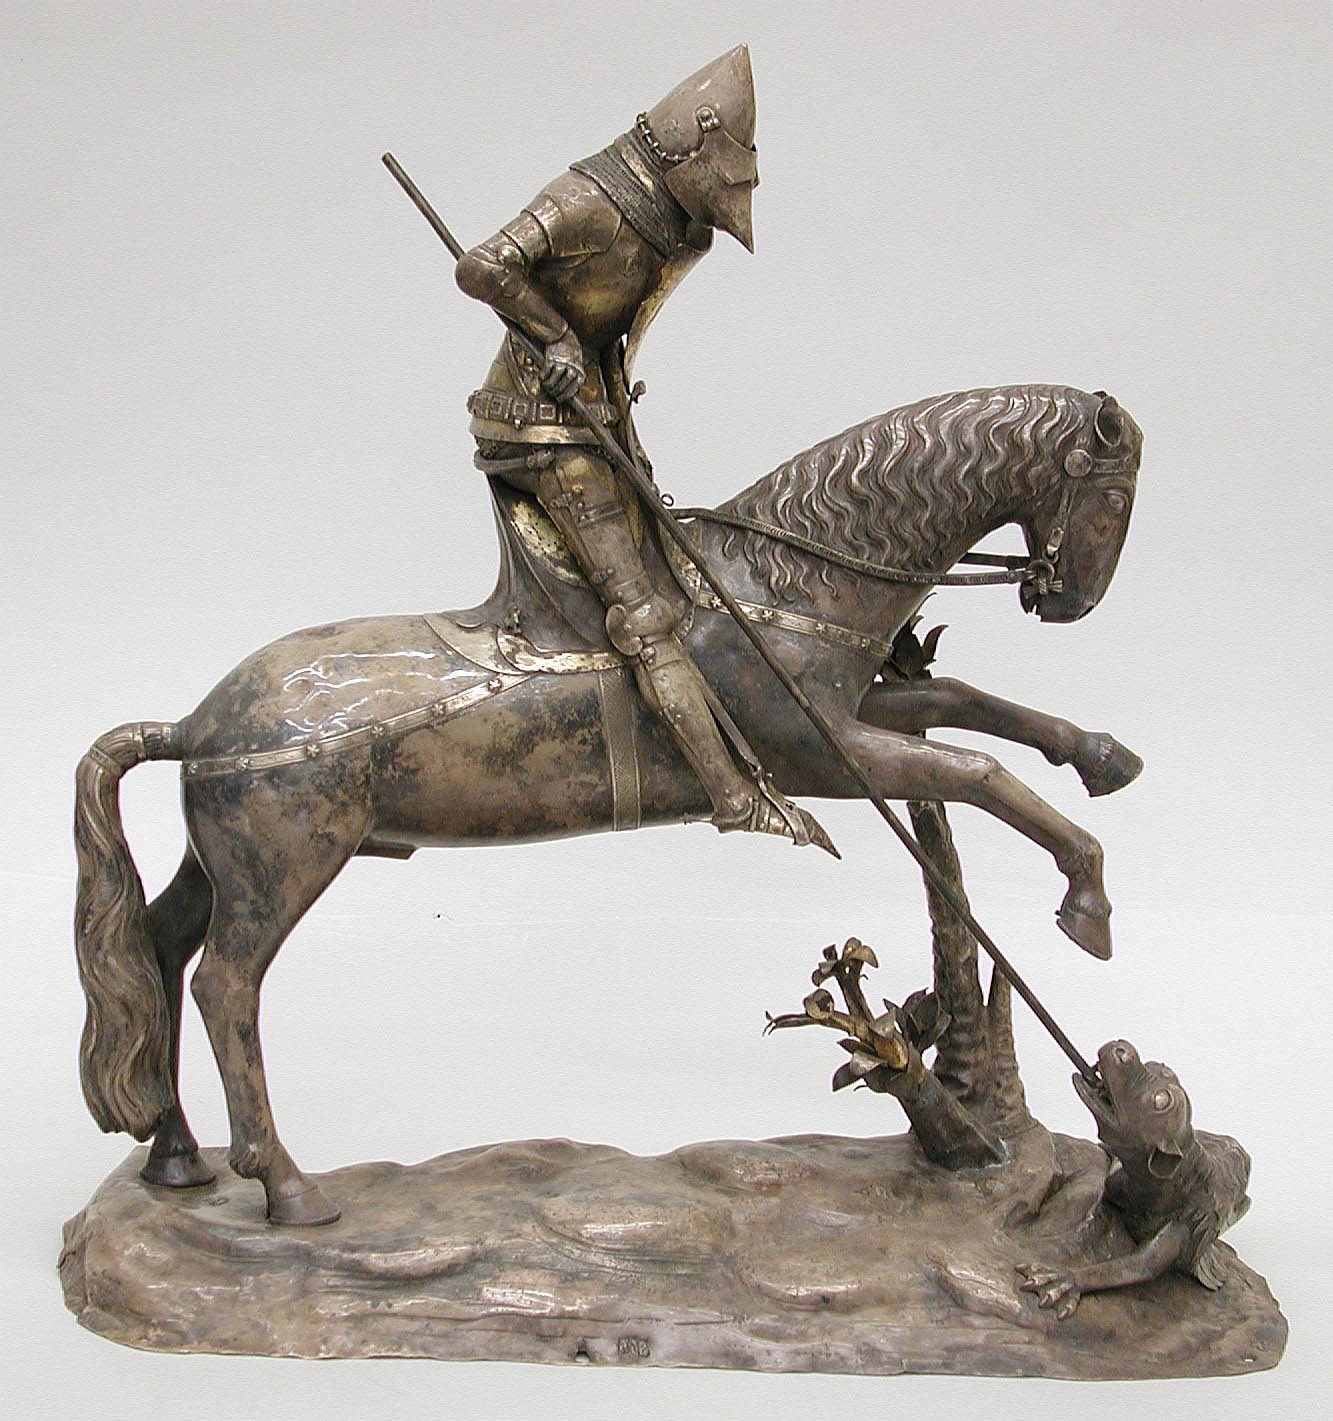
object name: statuette group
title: St. George and the Dragon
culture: french or italian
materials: silver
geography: italy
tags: dragons,horses,saint george